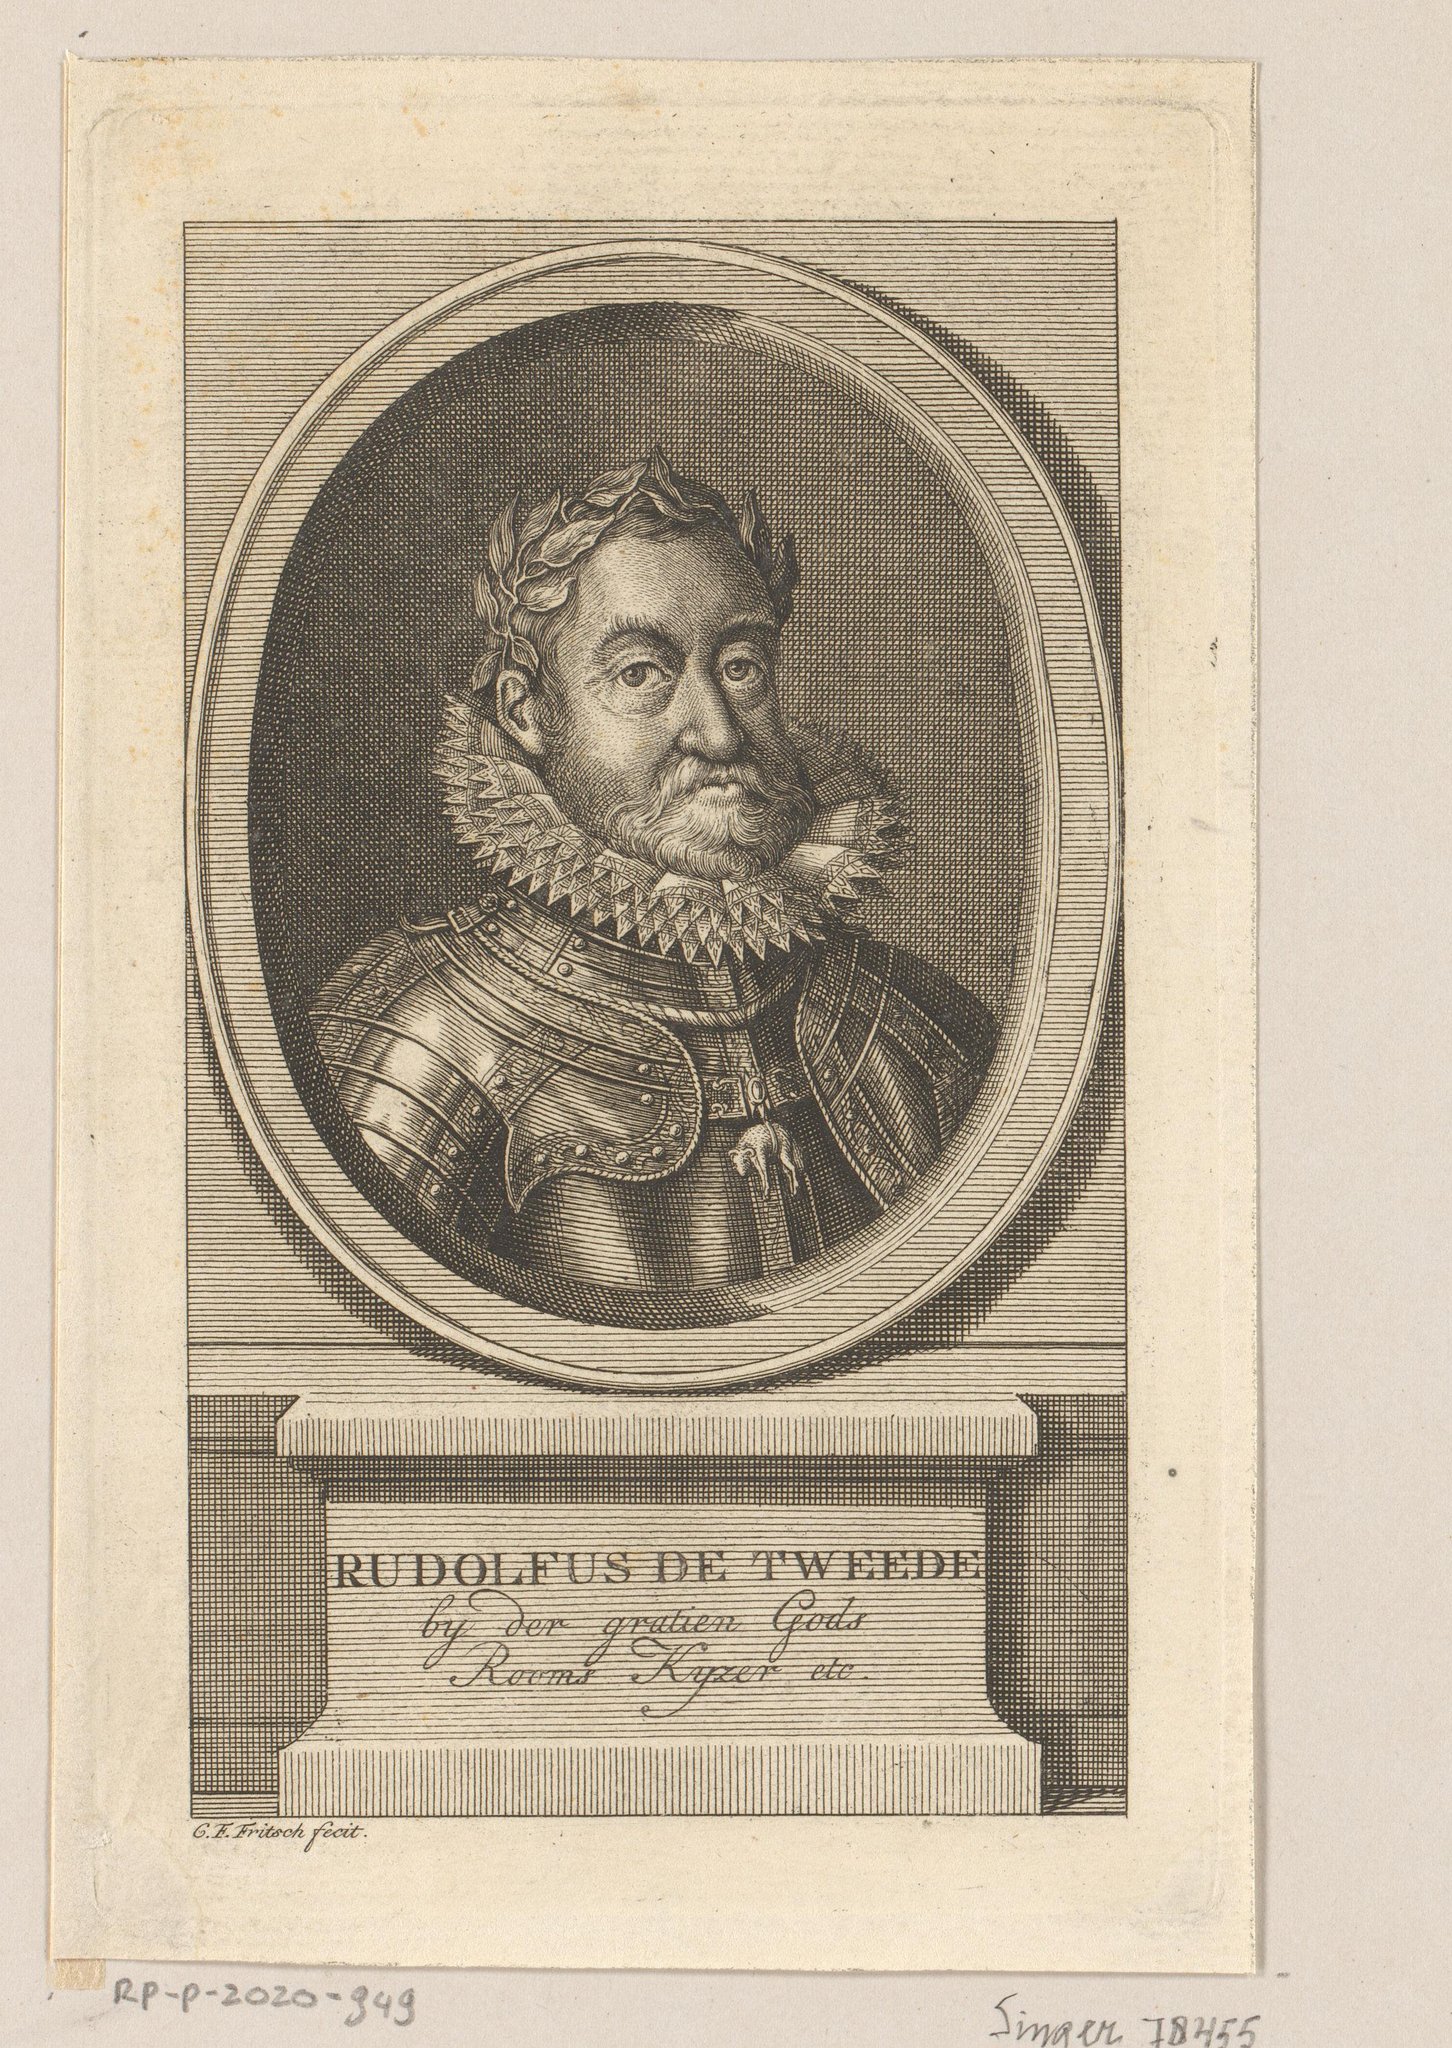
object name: book illustration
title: Rudolfus de tweede bij der gratien Gods Rooms kyzer etc.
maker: christian friedrich fritzsch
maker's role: print maker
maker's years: 1719-1774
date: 1753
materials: paper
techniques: engraving, etching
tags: vienna, prague, rudolf ii van habsburg (duits keizer), historical persons, emperor, crowning with laurel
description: Andere staat van prent gebruikt in: Meteren, Emanuel van. Historie van de oorlogen en geschiedenissen der Nederlanderen, en der zelver naburen: beginnende met den Jare 1315, en eindigende met den Jare 1611. 10. dln. Amsterdam: weduwe Nicolaas Goetzee, 1753, dl. 6. Ook gebruikt in latere edities.